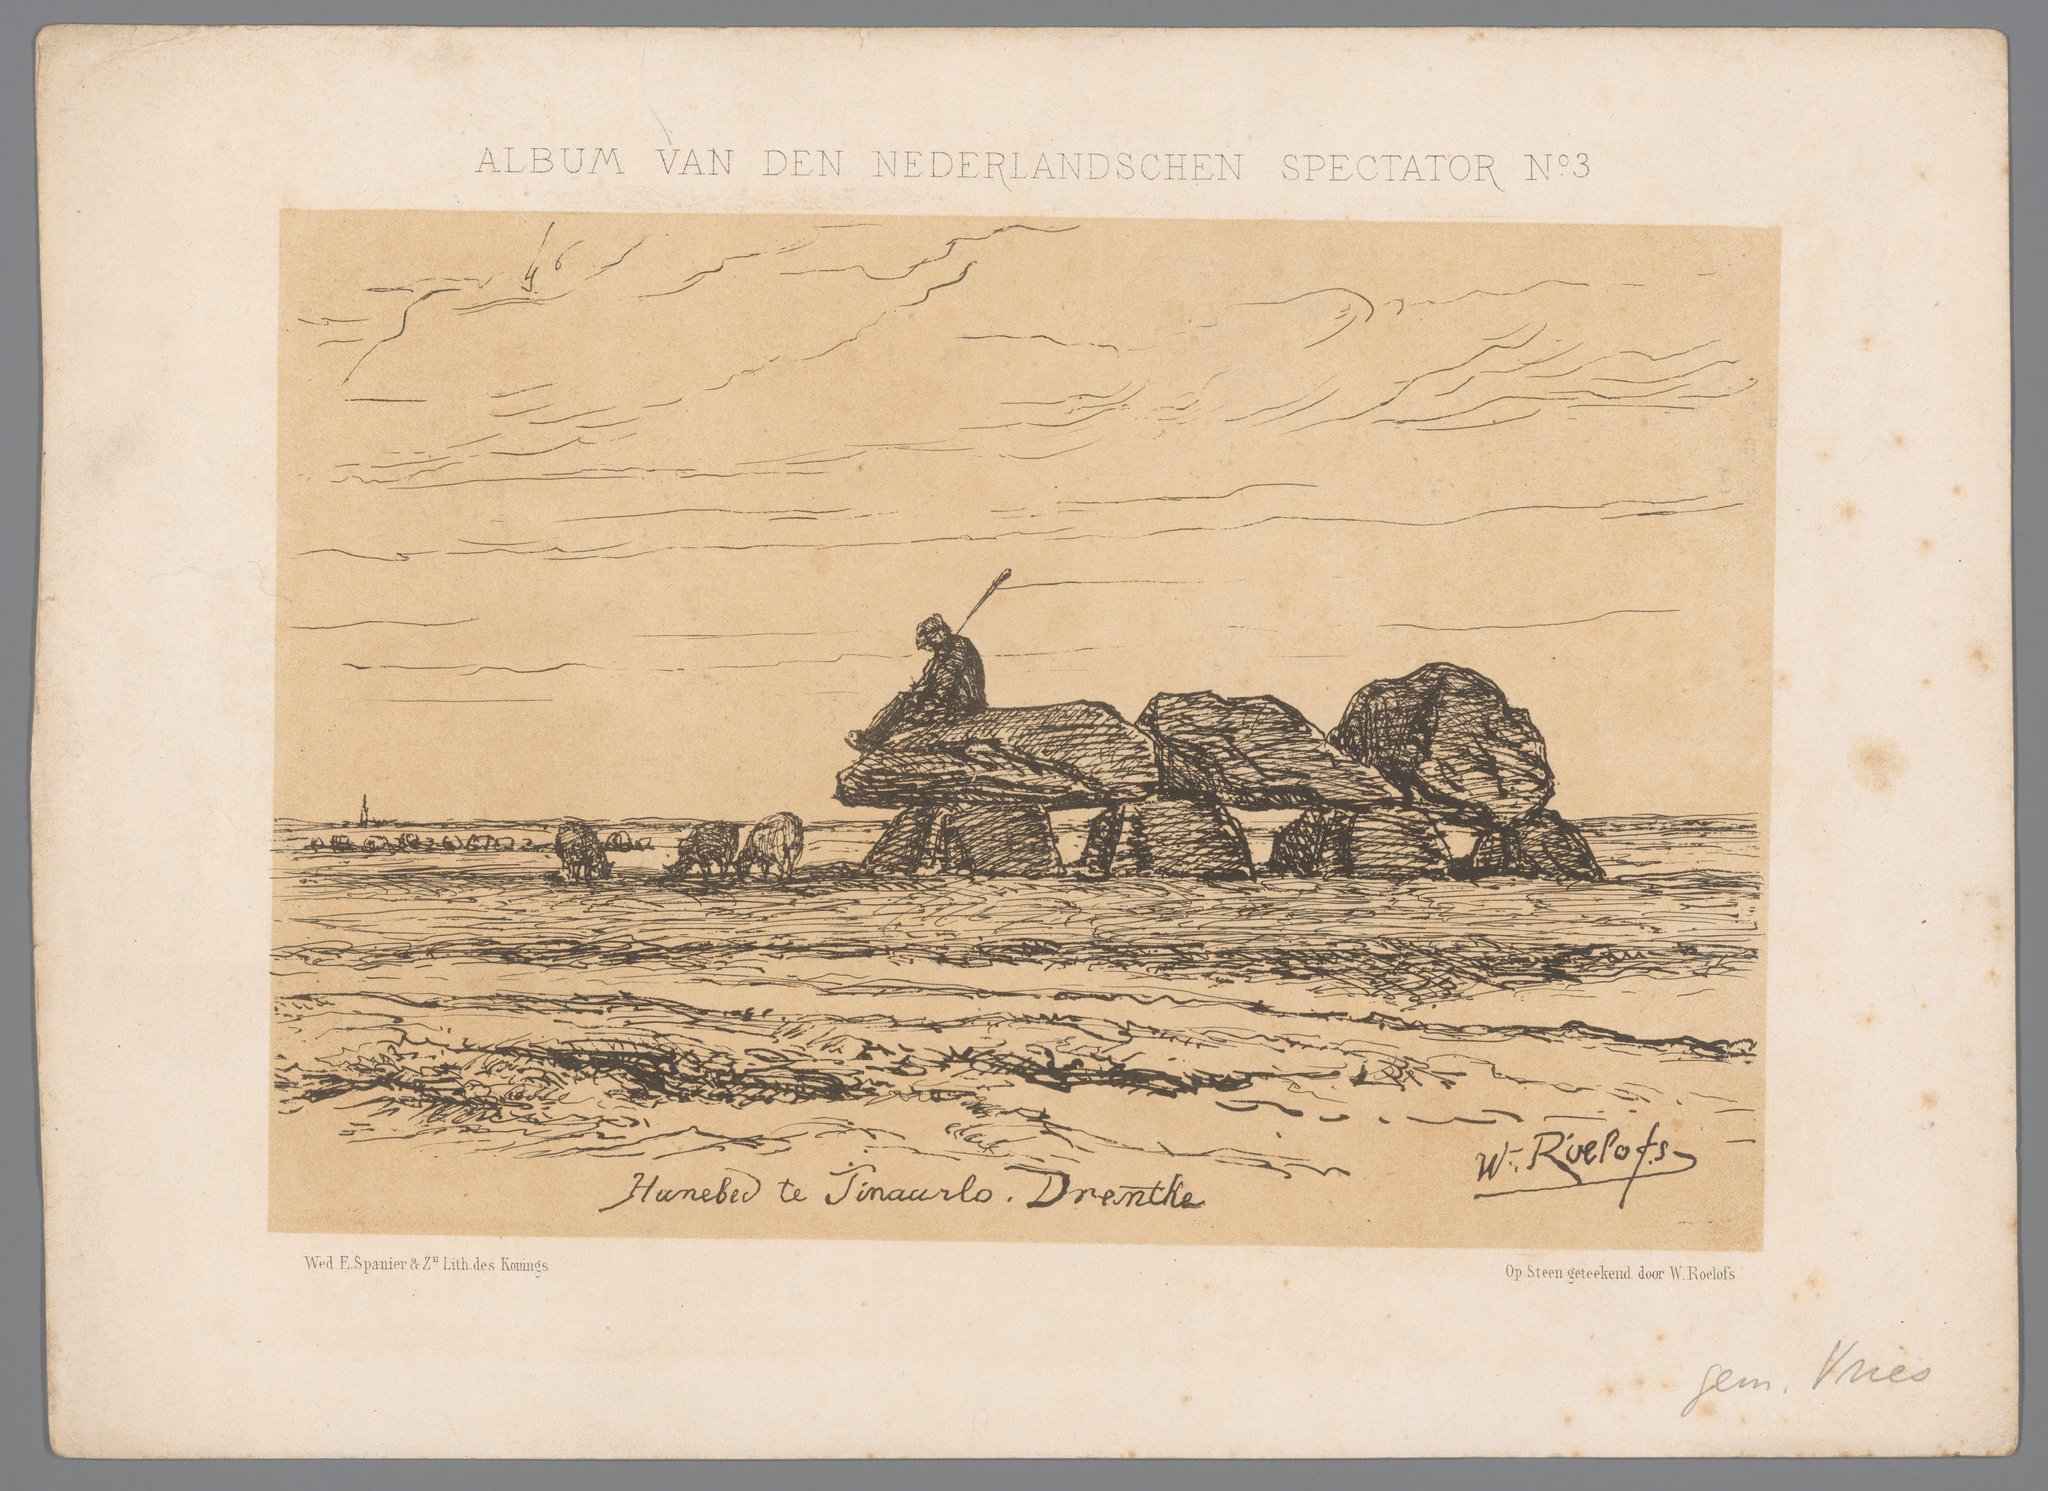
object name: print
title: Hunebed te Tinaarlo, Drenthe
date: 1869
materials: paper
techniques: tone lithography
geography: the hague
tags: megalithic chambered tomb, dolmen, resting - bb - out of doors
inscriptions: collector's mark: Lugt 2228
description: Prent uit: De Nederlandsche Spectator. Arnhem: D.A. Thieme, Den Haag: Martinus Nijhoff, 1869, tussen p. 316 en 317.